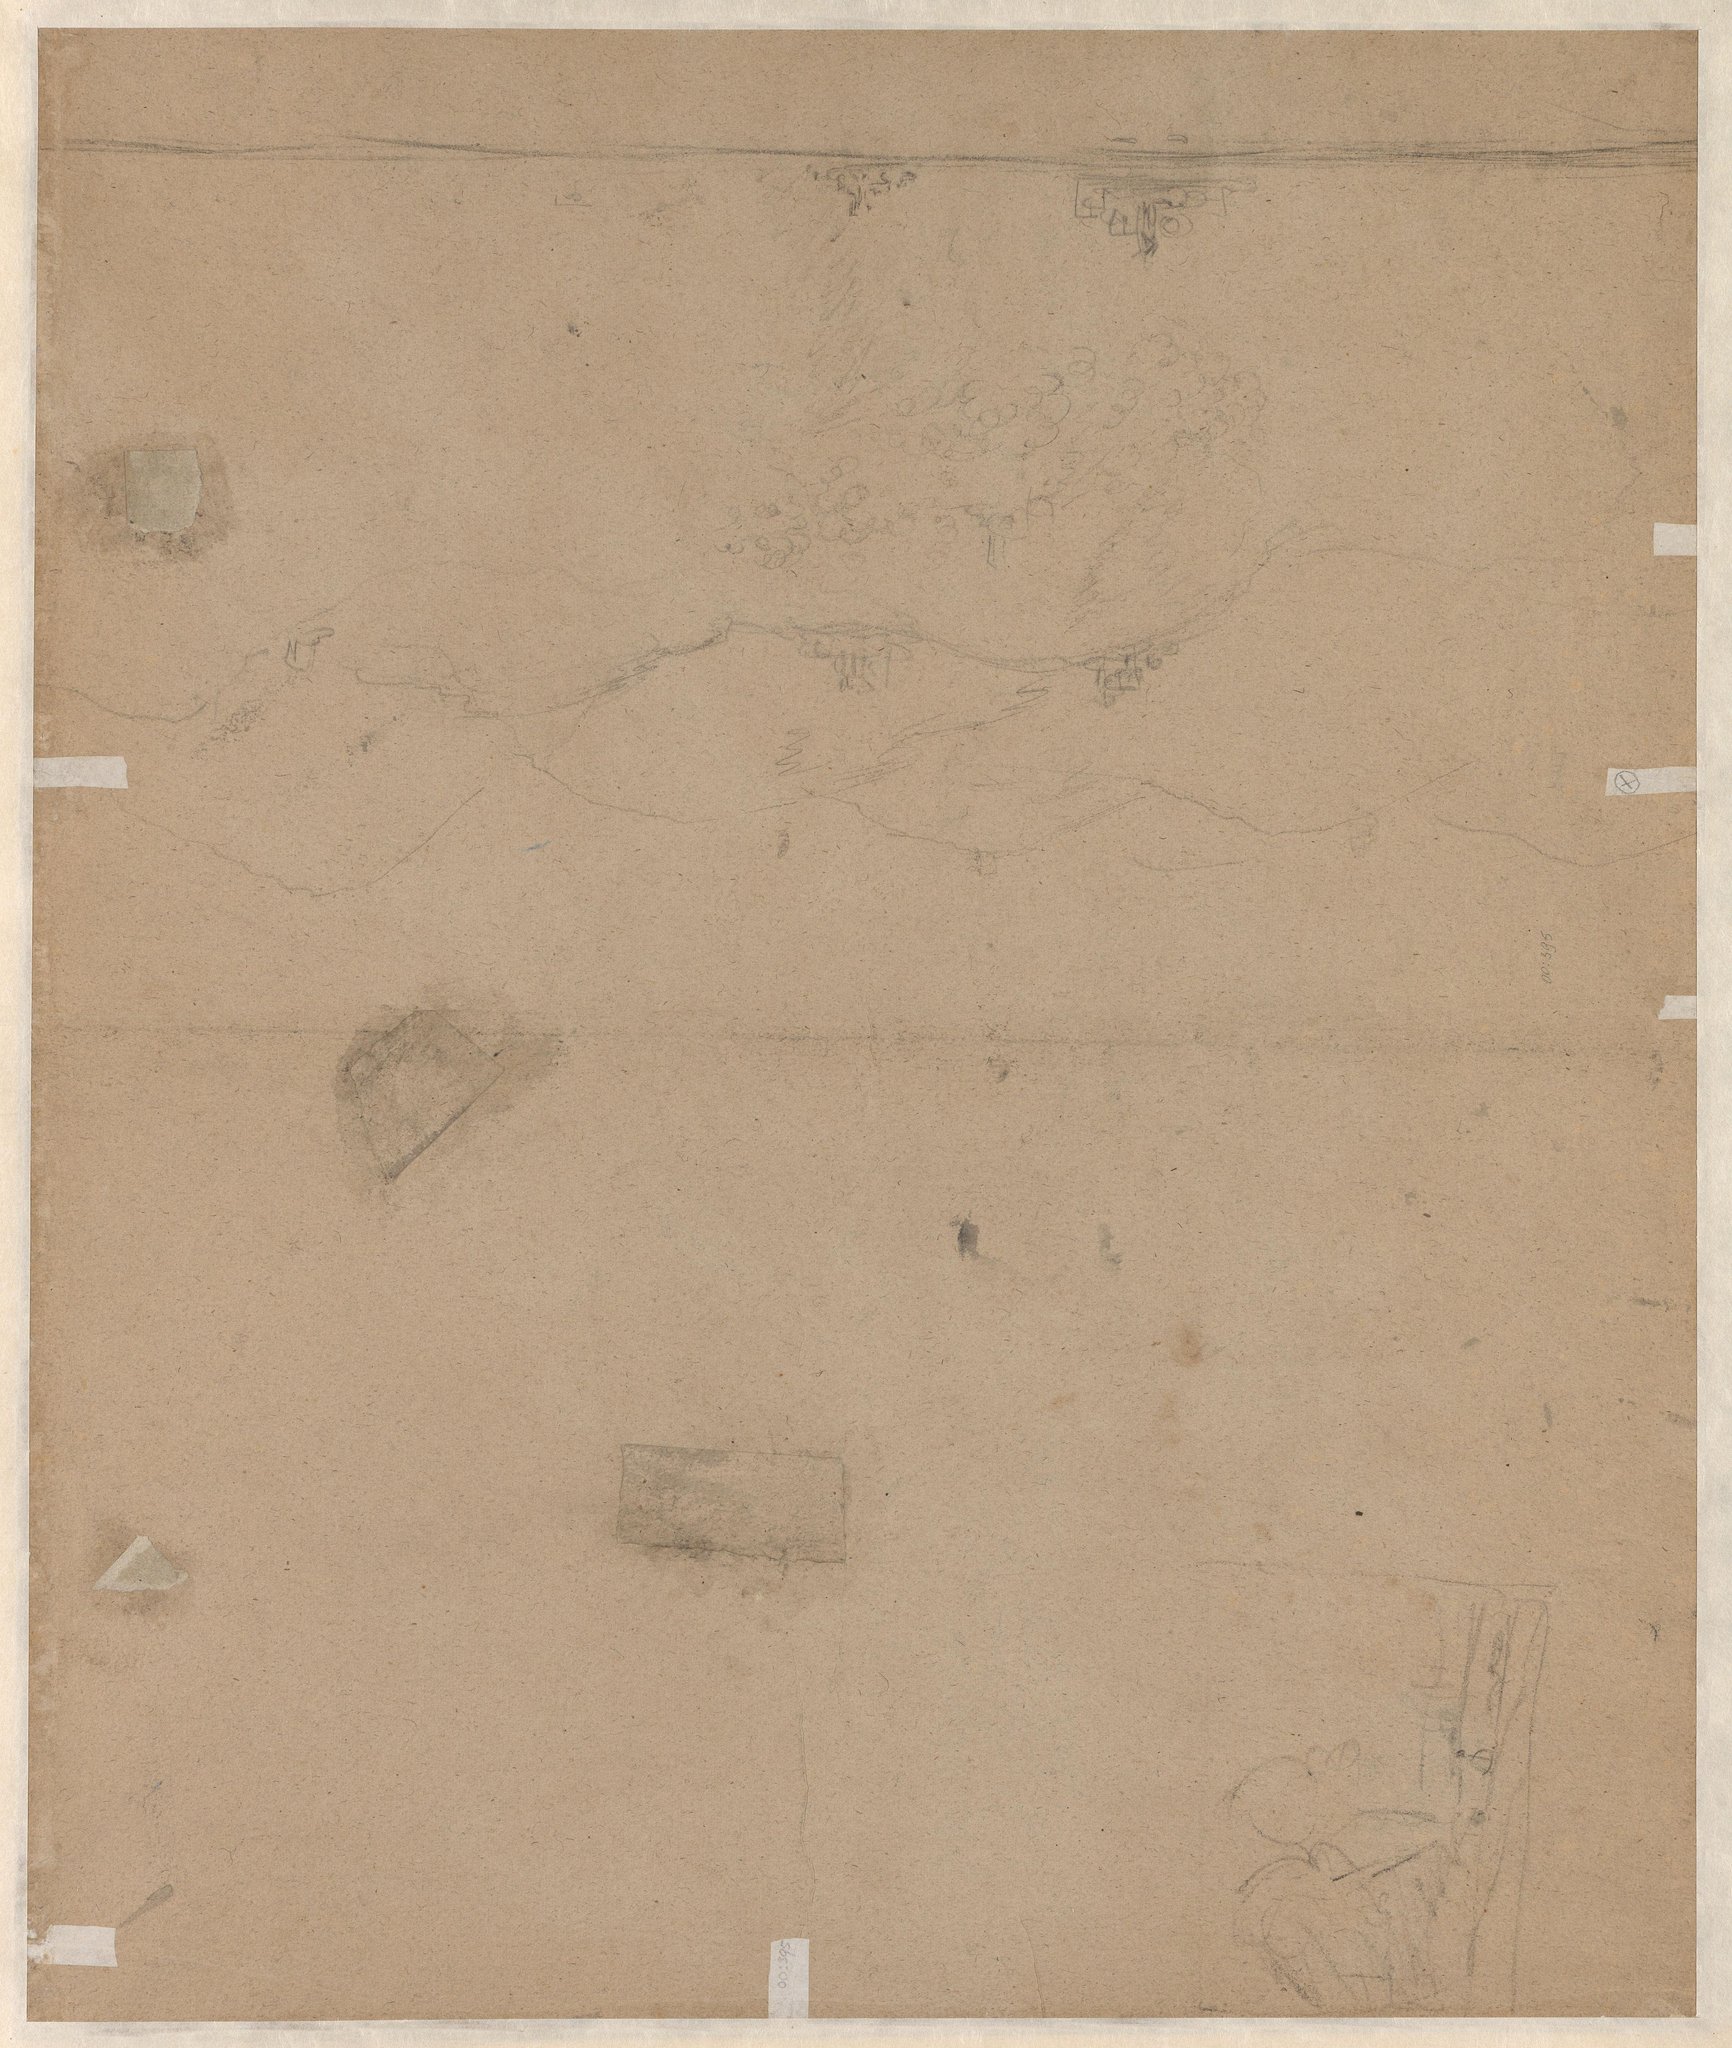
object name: drawing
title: Schetsen van een heuvellandschap en bomen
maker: anthonie waterloo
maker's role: draughtsman, painter, print maker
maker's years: 1609-1690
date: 1619-1690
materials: chalk, paper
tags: low hill country